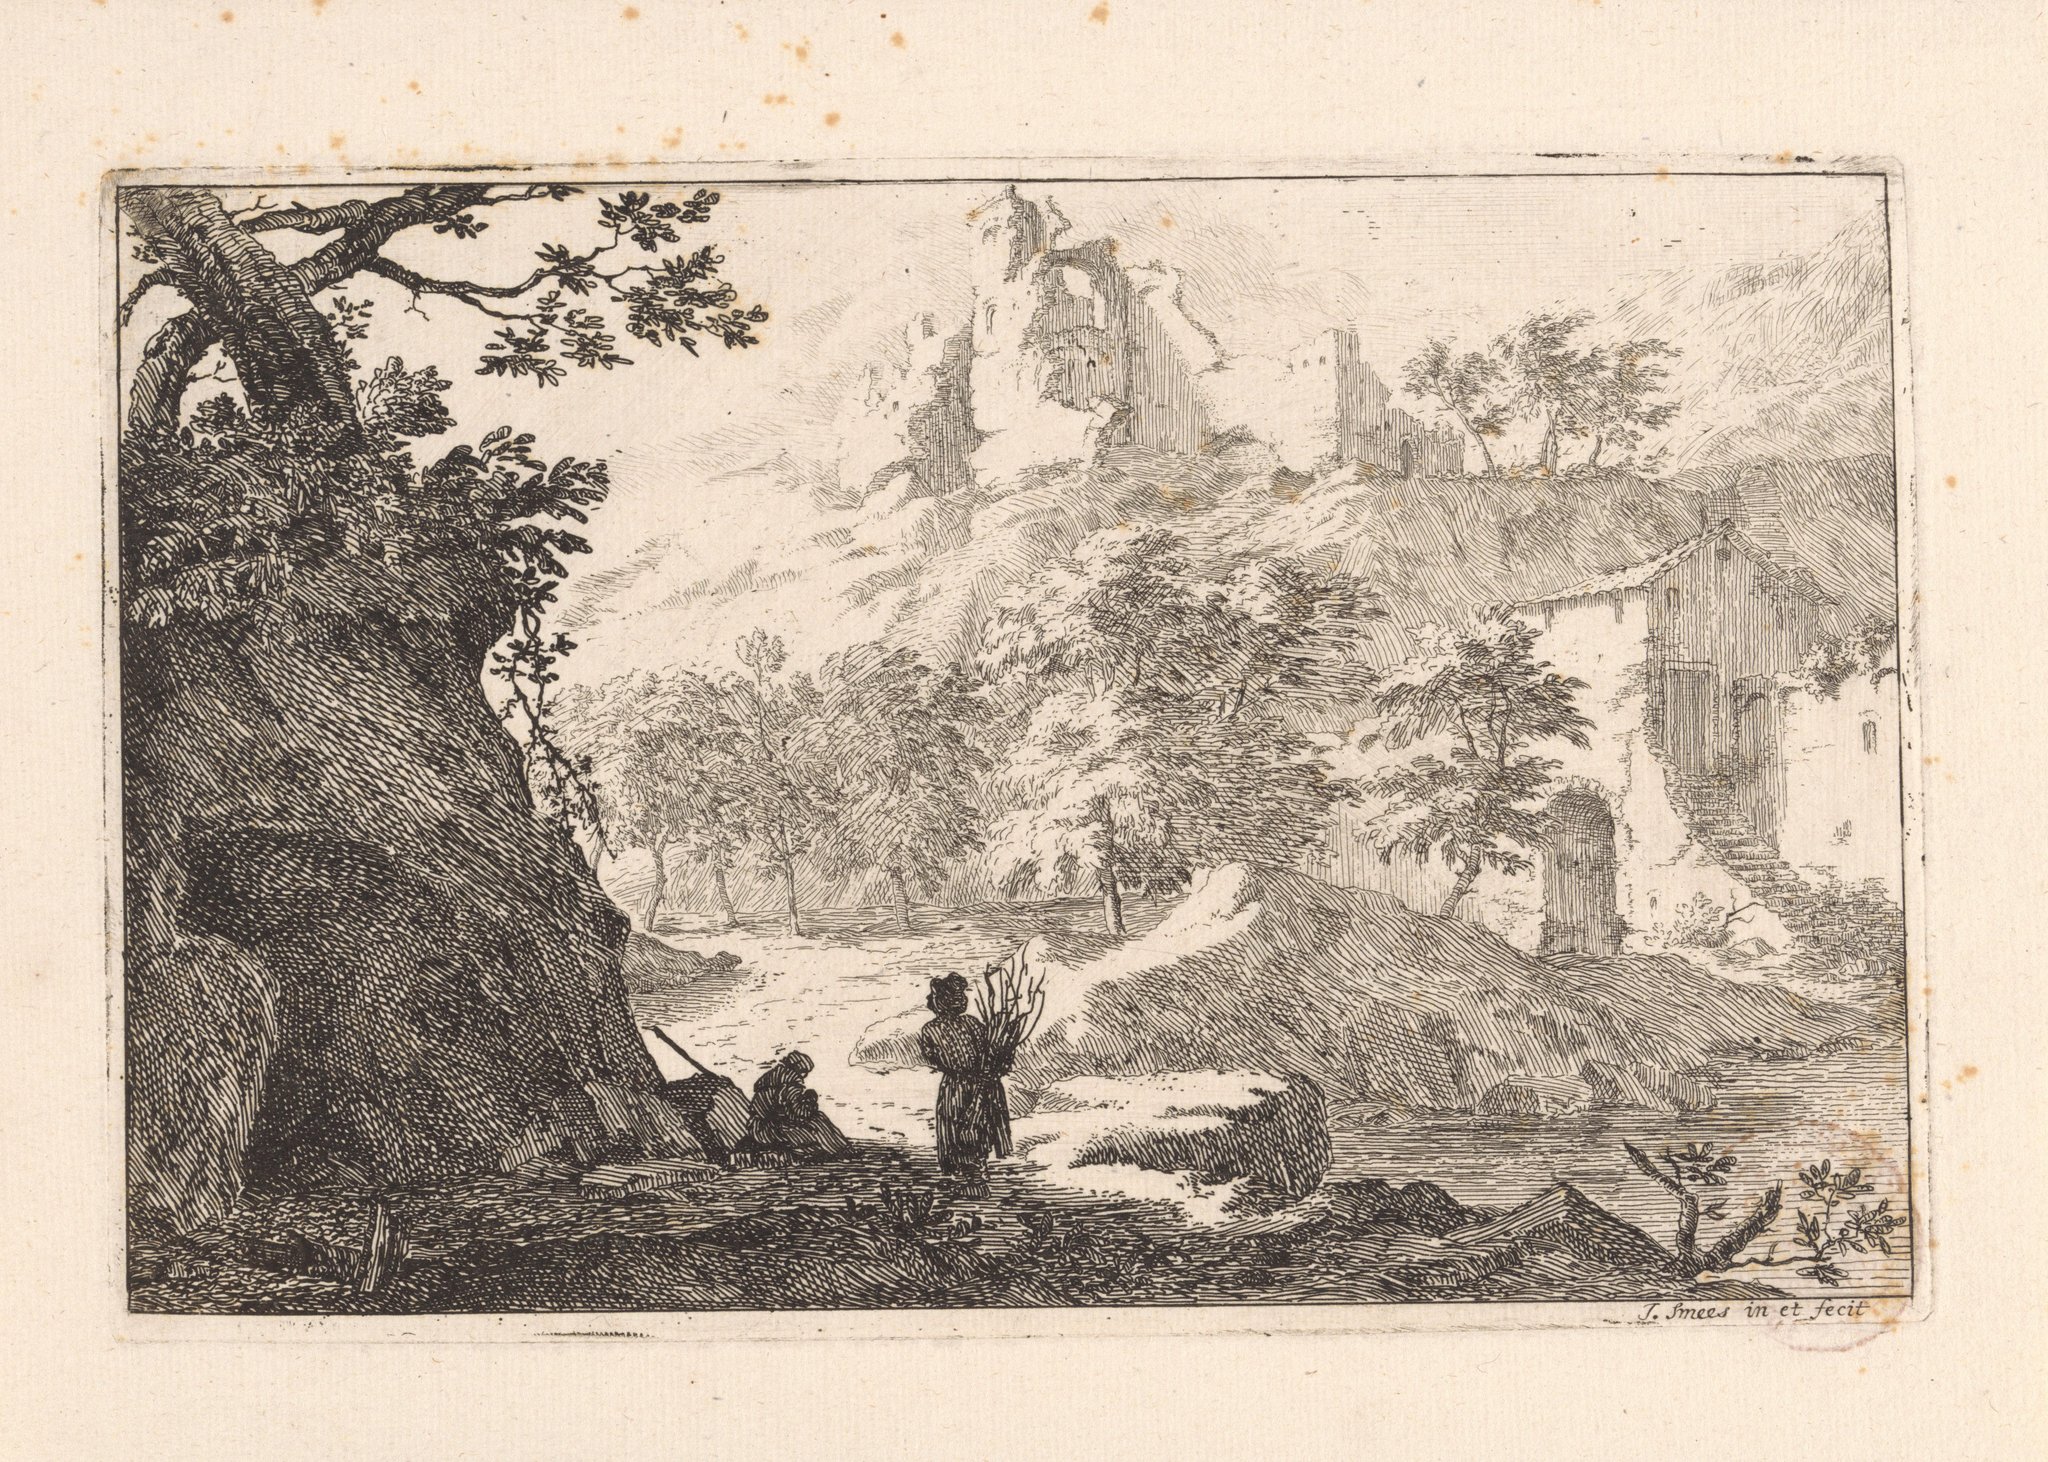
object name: print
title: Landschap met boerderij en ruïne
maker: jan smees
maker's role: draughtsman, print maker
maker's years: 1670-1729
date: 1705-1729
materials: paper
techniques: etching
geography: amsterdam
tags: landscape with ruins - ii - ideal landscapes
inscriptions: collector's mark: Lugt 240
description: Heuvellandschap met een boerderij aan het water. Op een heuvel ligt de ruïne van een kasteel. Op de voorgrond twee mensen, van wie er één een takkenbos op de rug draagt.